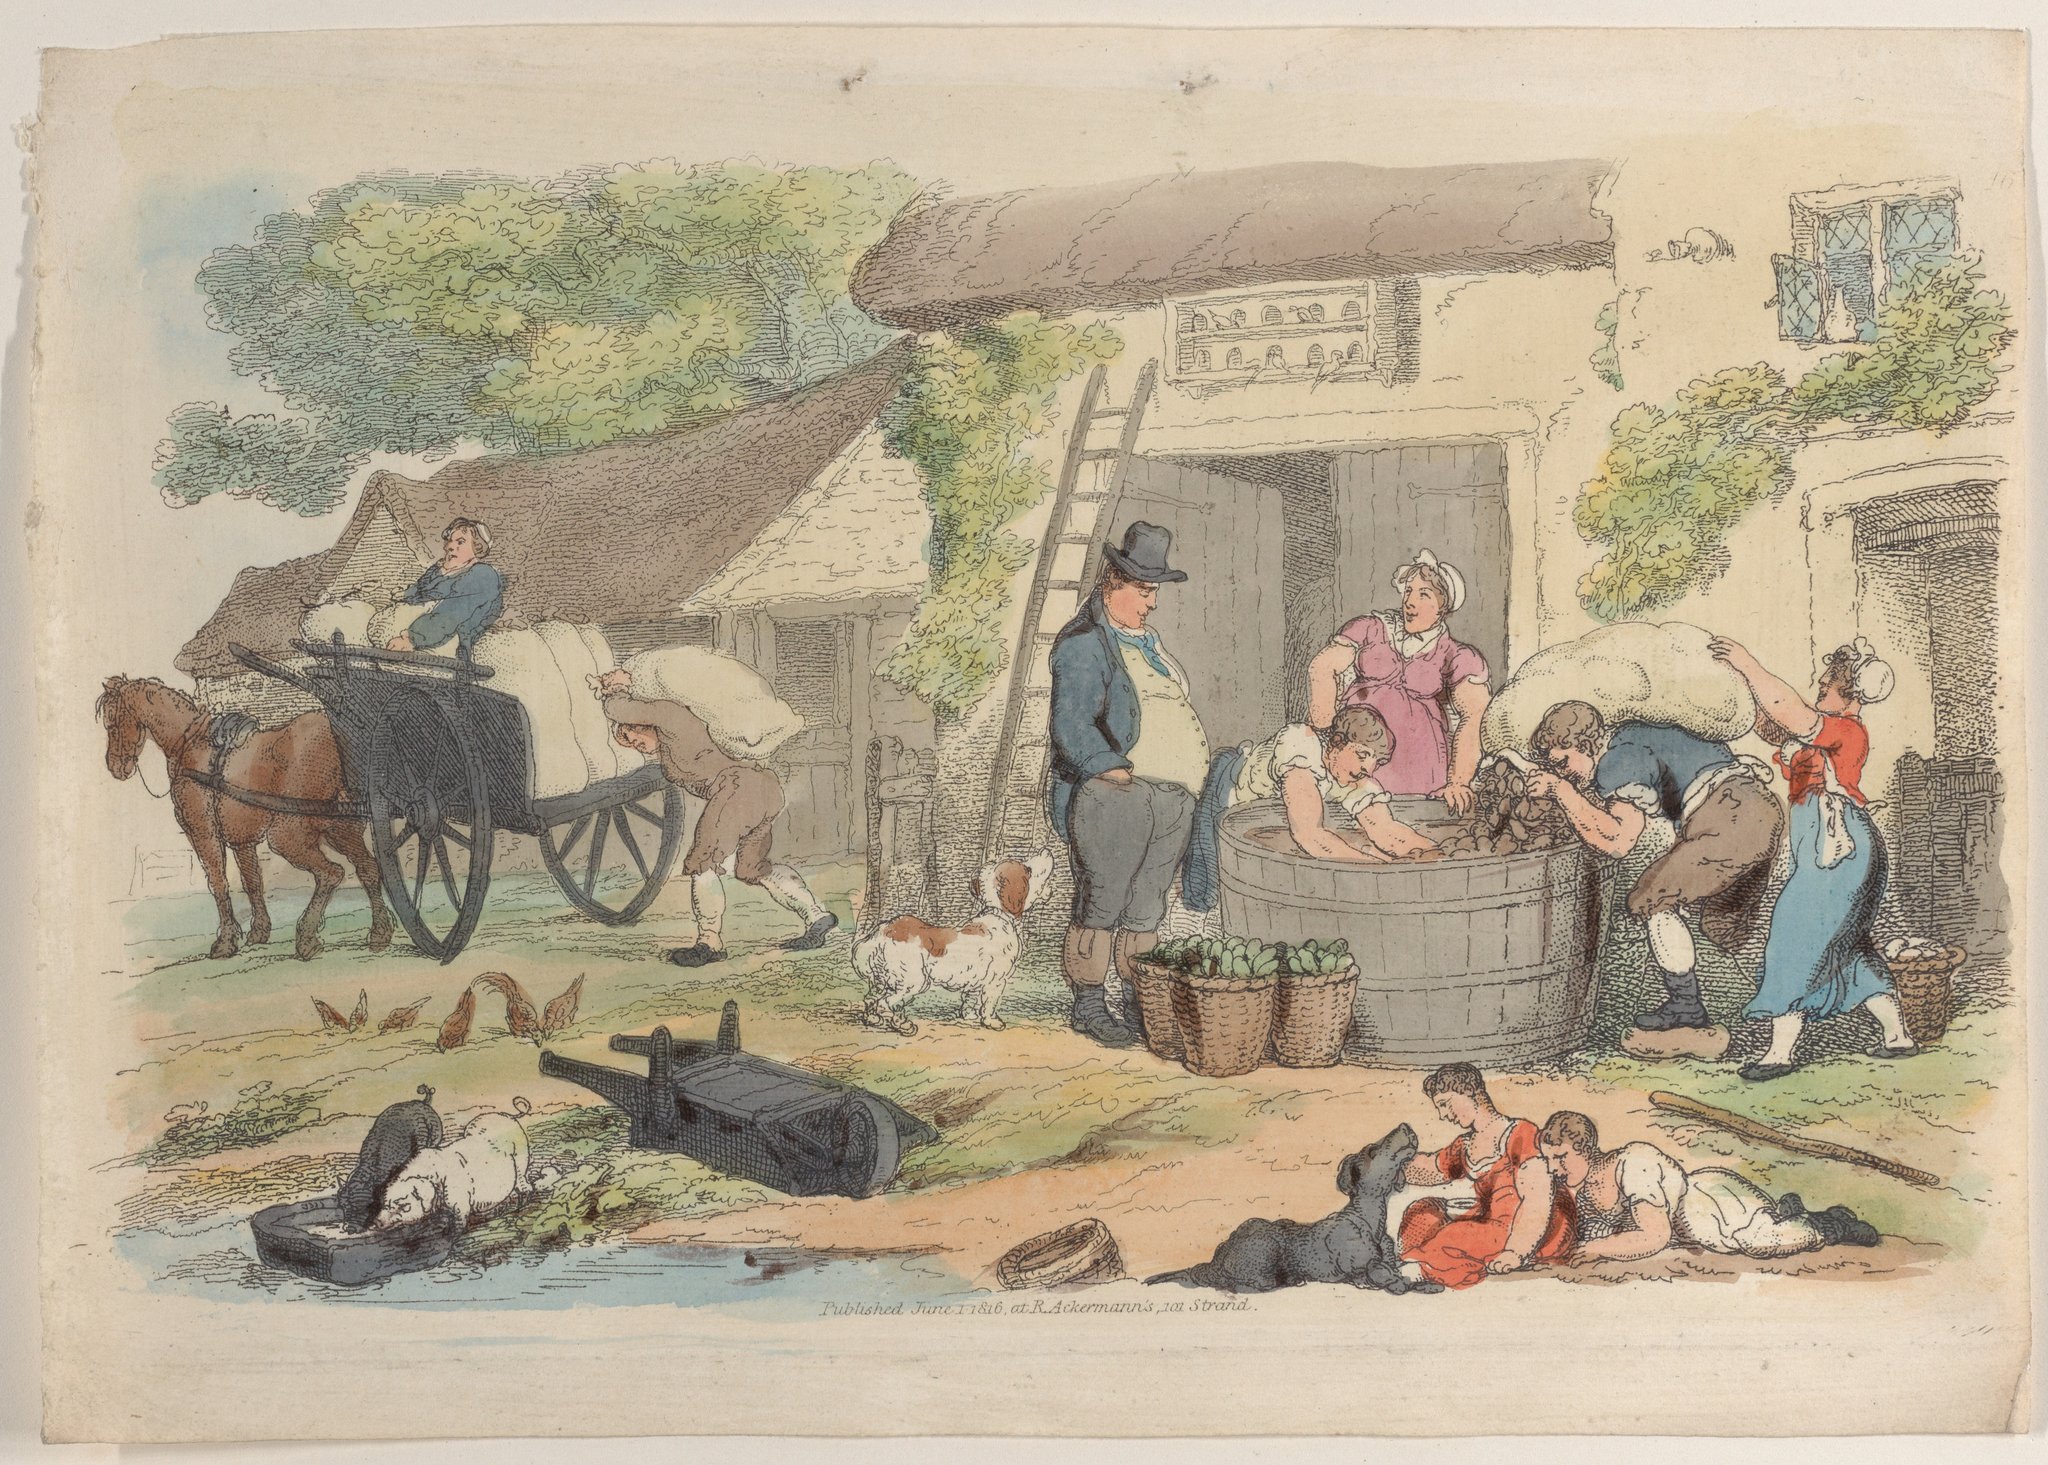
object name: print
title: Plate 16, from "World in Miniature"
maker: thomas rowlandson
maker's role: artist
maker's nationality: british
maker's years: 1757-1827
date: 1816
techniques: etching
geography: london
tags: barns,men,women,dogs,carts